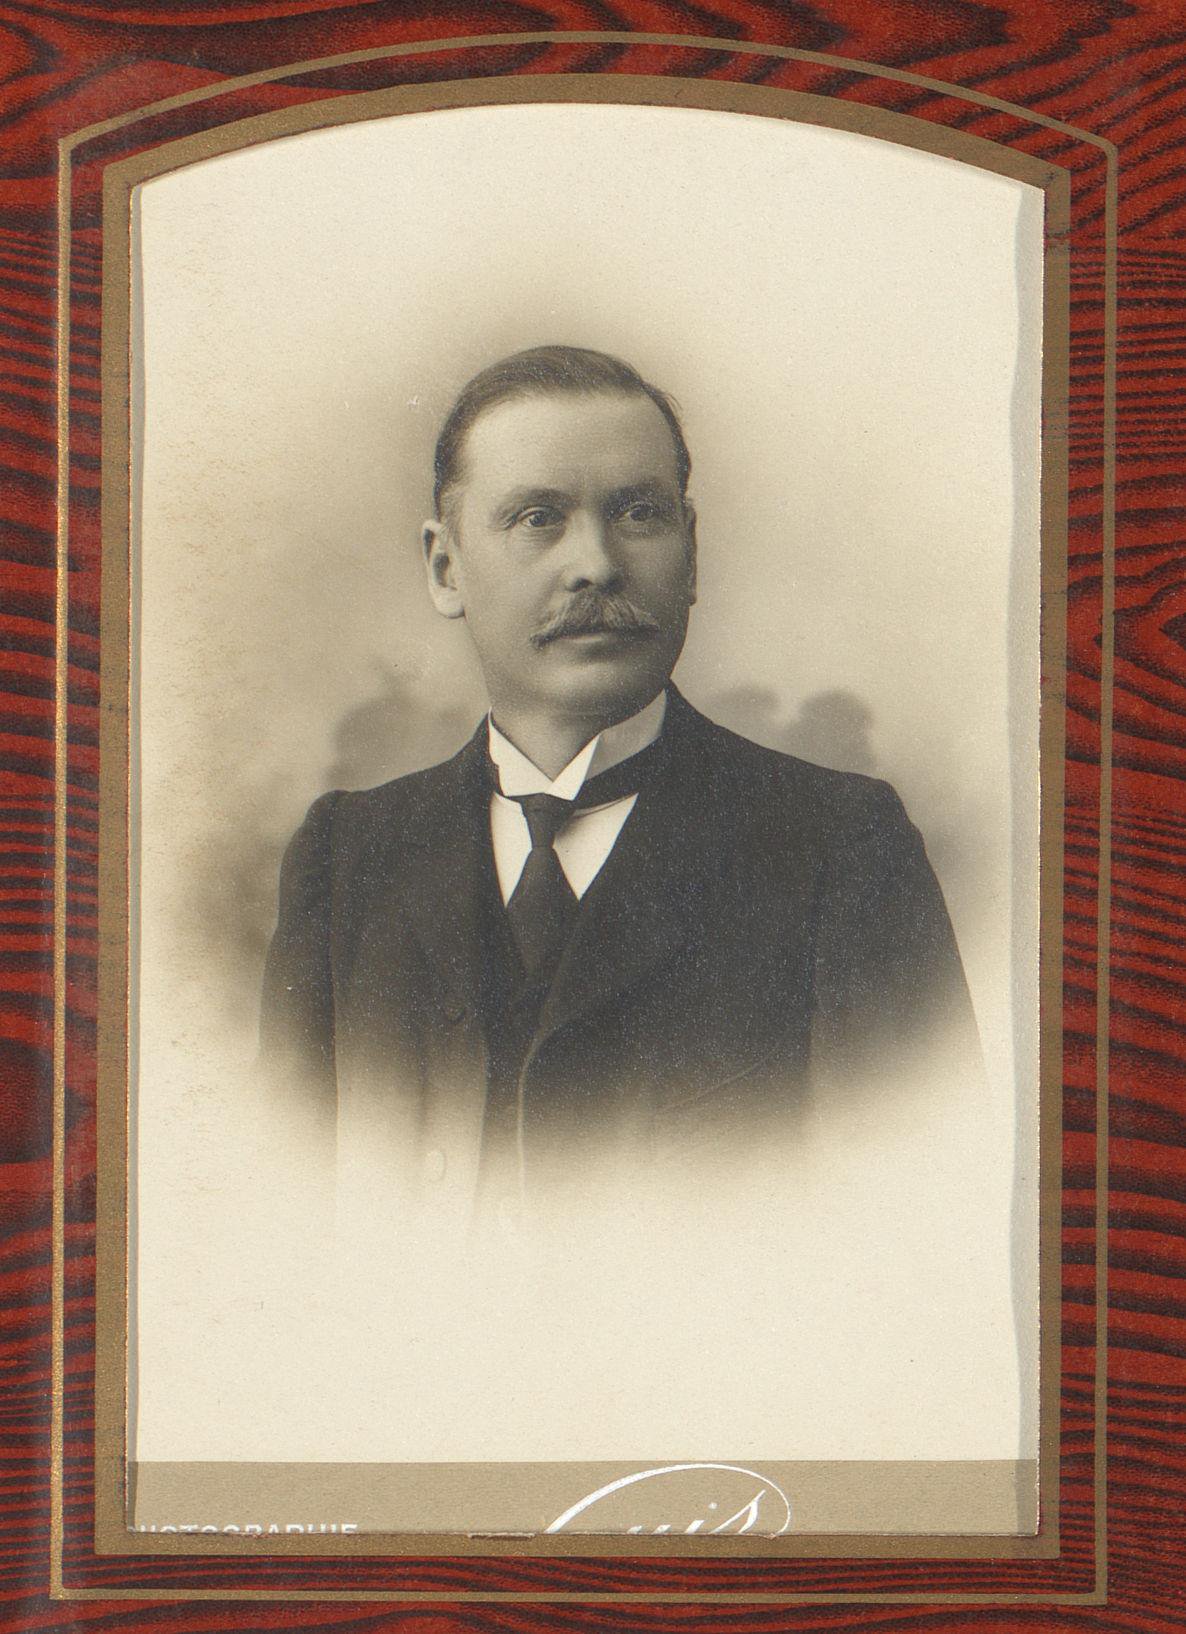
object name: cabinet photograph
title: Portret van een man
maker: louis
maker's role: fotograaf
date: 1860-1920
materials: cardboard, photographic support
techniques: gelatin silver print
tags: adult man, historical persons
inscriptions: name: ‘Photographe/ de la/ Porte St. Martin/ 29. Bd St. Martin/ Paris’